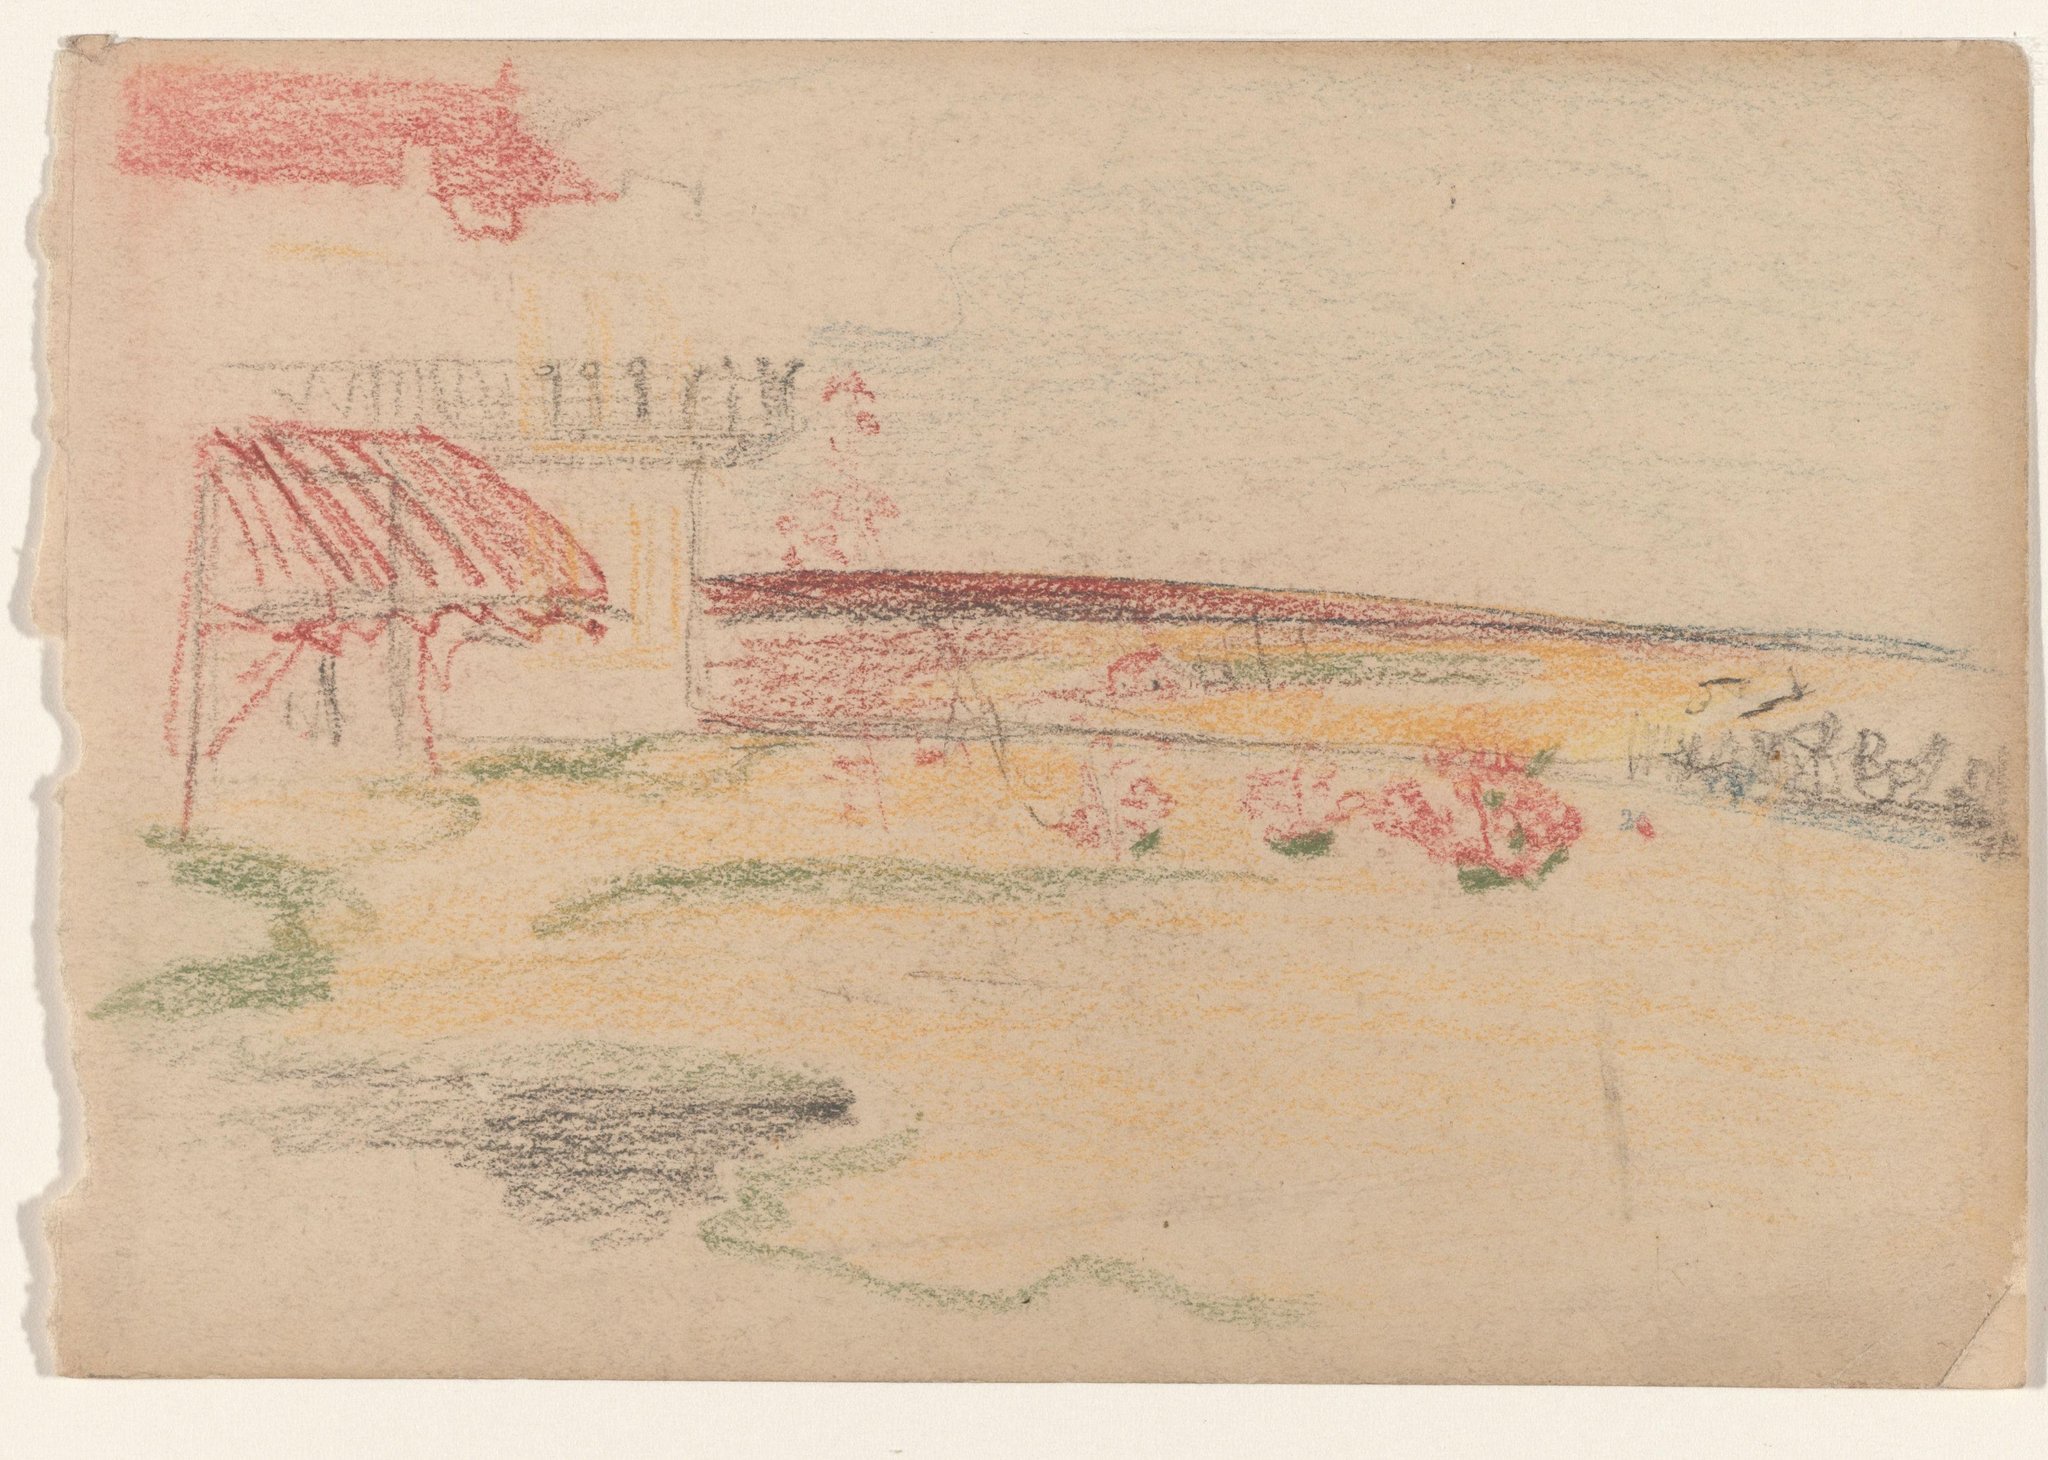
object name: drawing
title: Tuin achter een huis met een luifel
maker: carel adolph lion cachet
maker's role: draughtsman, print maker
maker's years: 1864-1945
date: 1874-1945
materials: chalk, paper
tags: garden